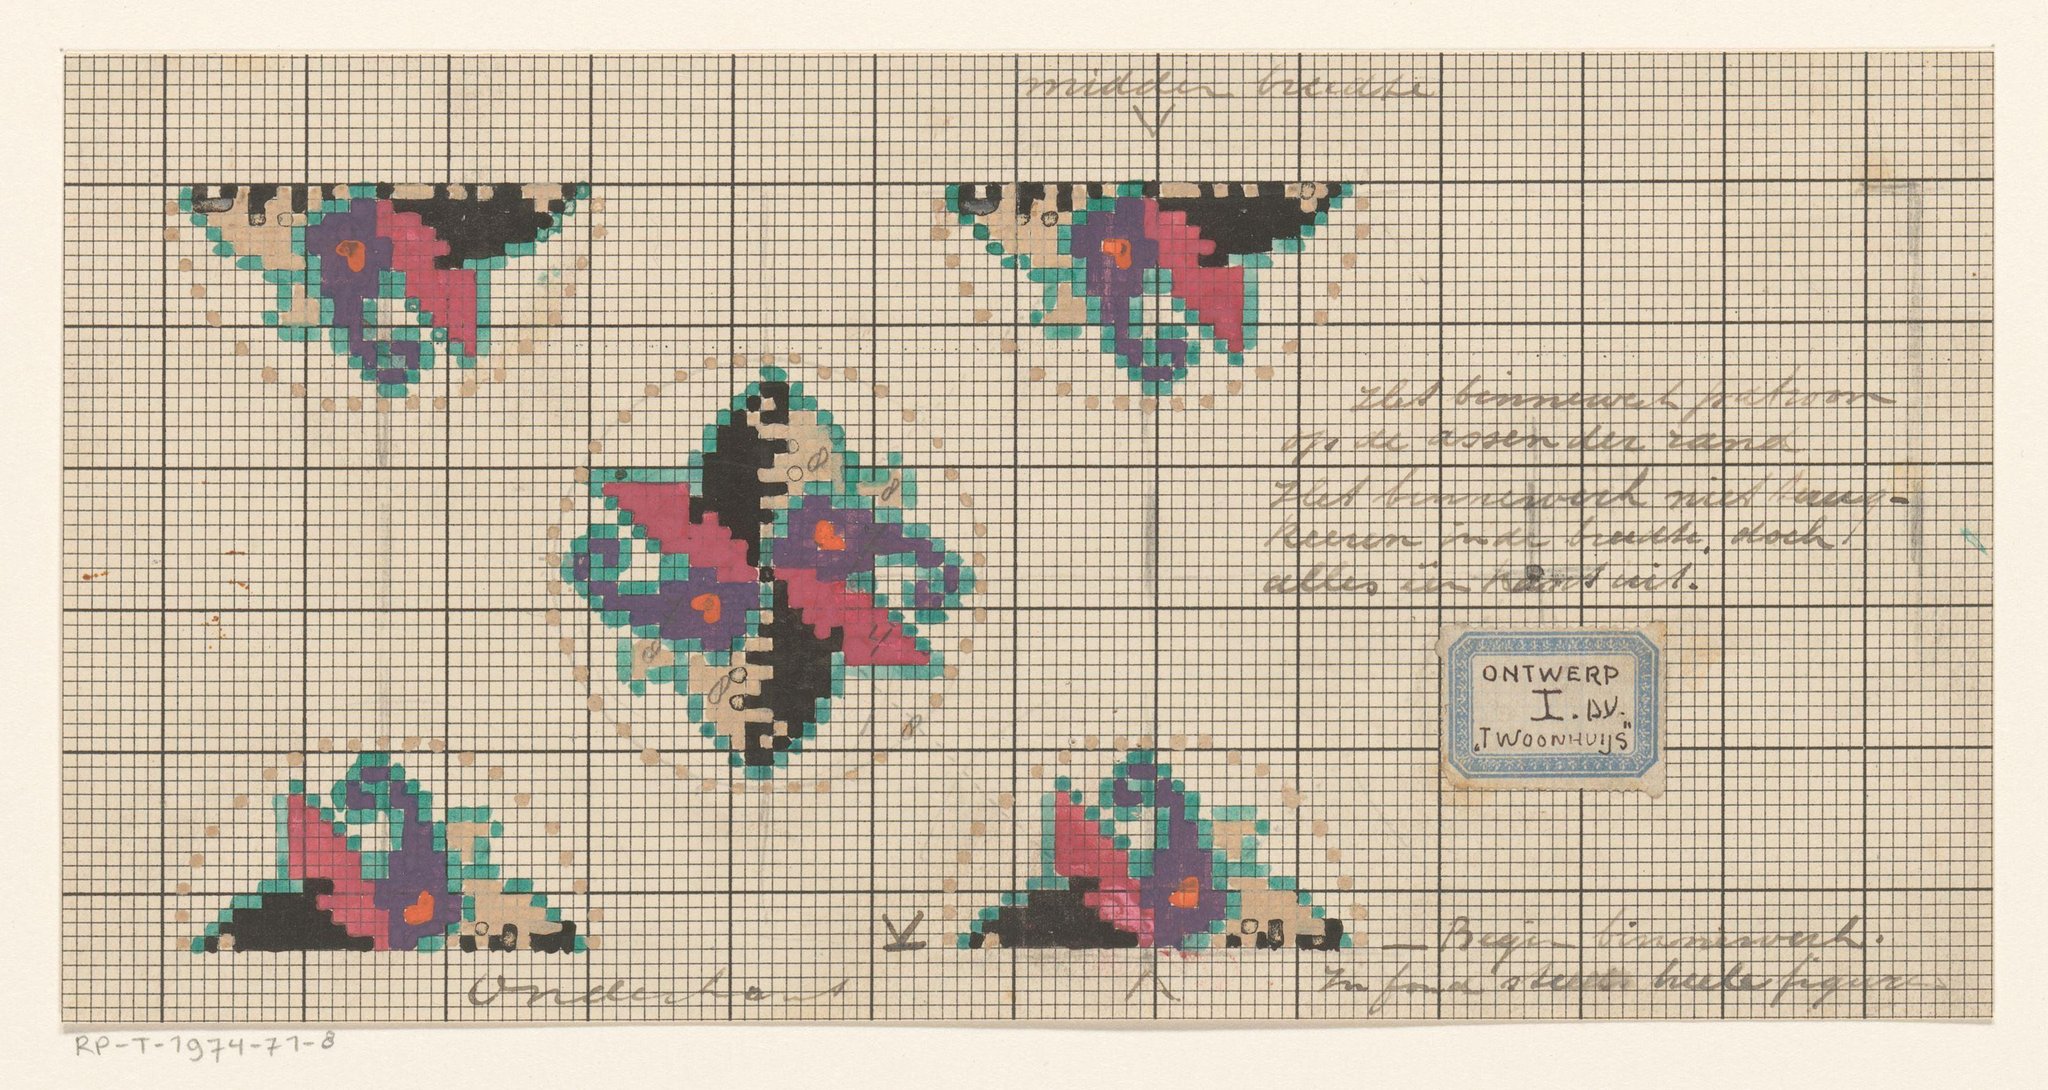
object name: drawing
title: Ontwerp voor een tapijt met floraal patroon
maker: dirk verstraten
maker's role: designer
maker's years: 1892-1946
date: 1907-1930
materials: paint, paper, pencil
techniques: brush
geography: amsterdam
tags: flowers ~ ornament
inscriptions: collector's mark: ‘R:MVS’, label: ‘ONTWERP/ I. N.V./ "T WOONHUIJS"’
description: Ontwerp voor het weefpatroon voor een deel van een tapijt. Het ontwerp is voorzien van nummers.